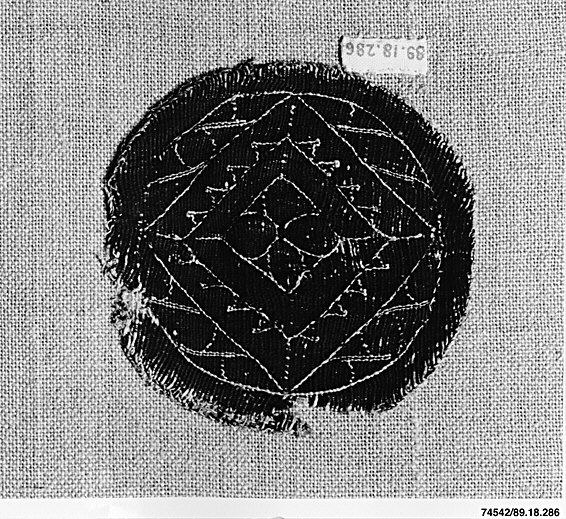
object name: textile fragment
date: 201-400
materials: linen, wool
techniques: weave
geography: egypt